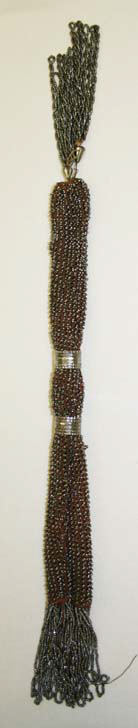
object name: miser's purse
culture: american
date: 1867-1900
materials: cotton